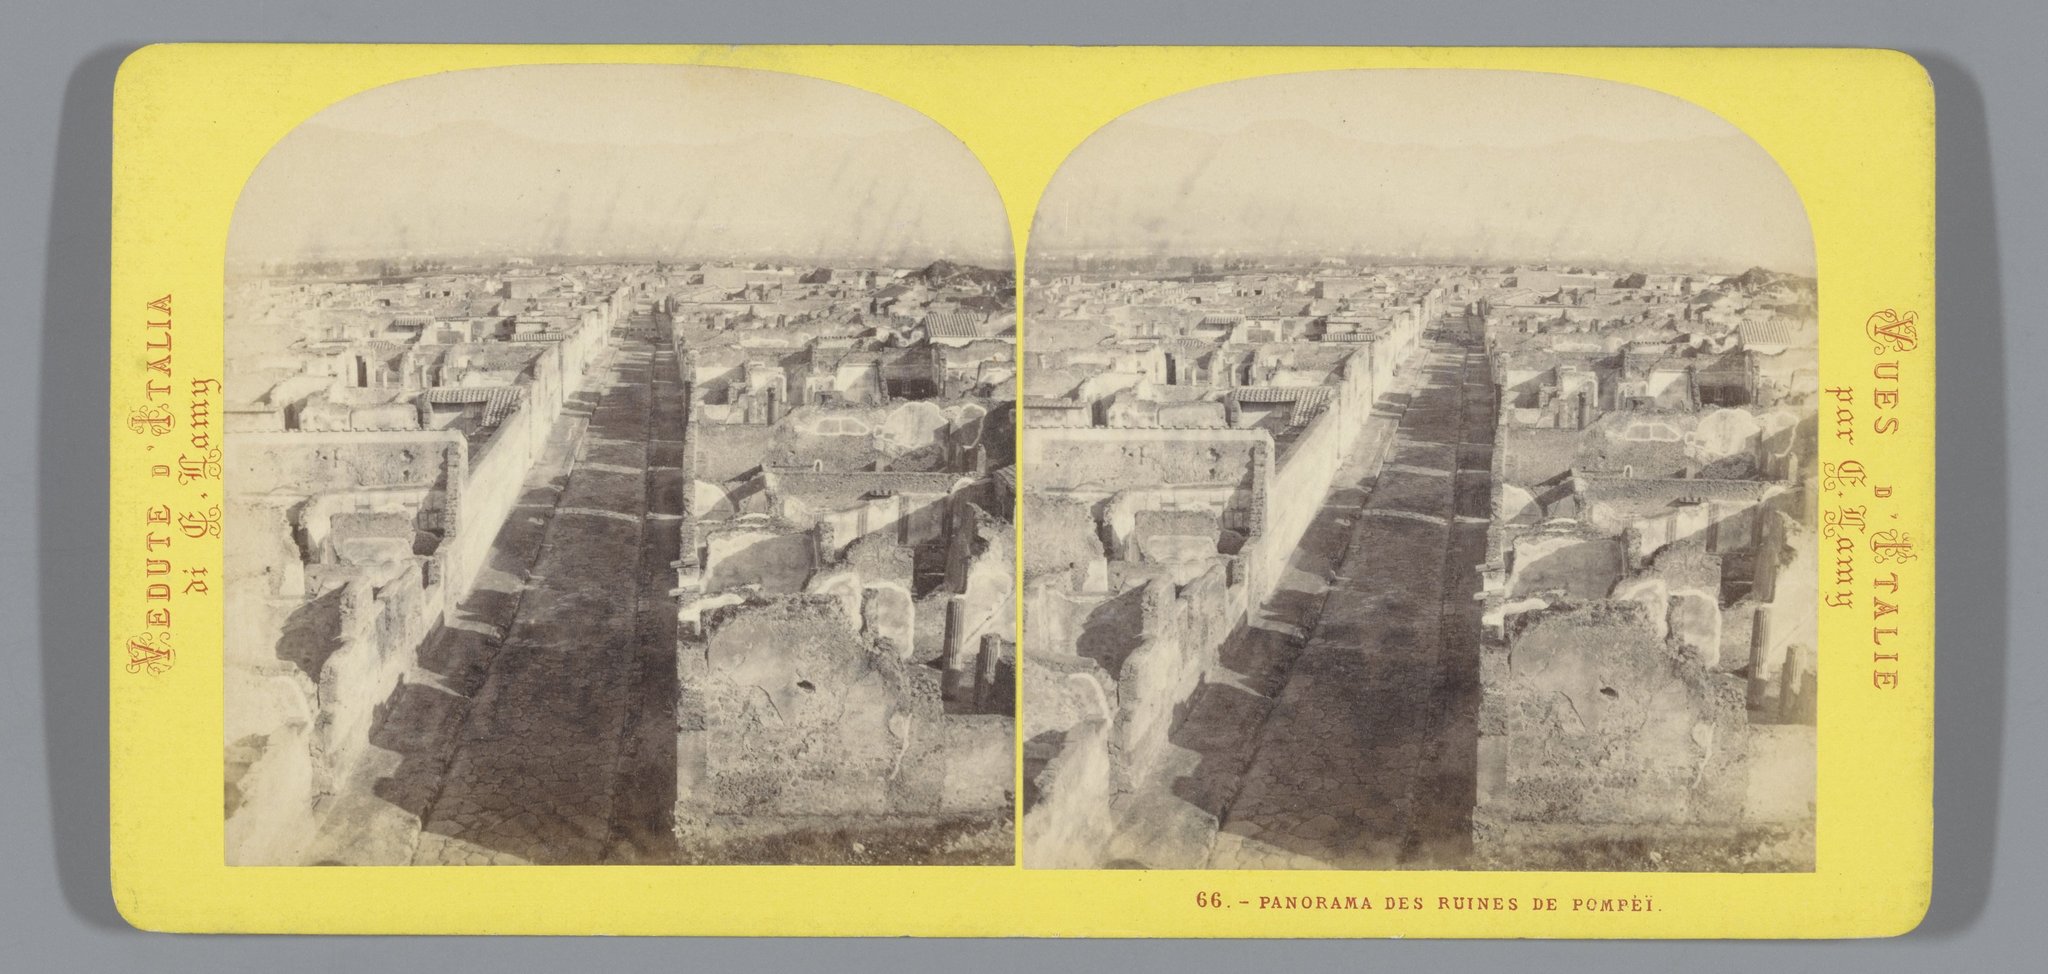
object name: stereograph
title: Ruïnes van Pompeï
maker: ernest eléonor pierre lamy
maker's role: publisher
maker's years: 1828-1900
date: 1861-1878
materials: cardboard, paper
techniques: albumen print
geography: pompeii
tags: ruin of a building ~ architecture, landscape with ruins, pompeii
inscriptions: number: ‘66.’